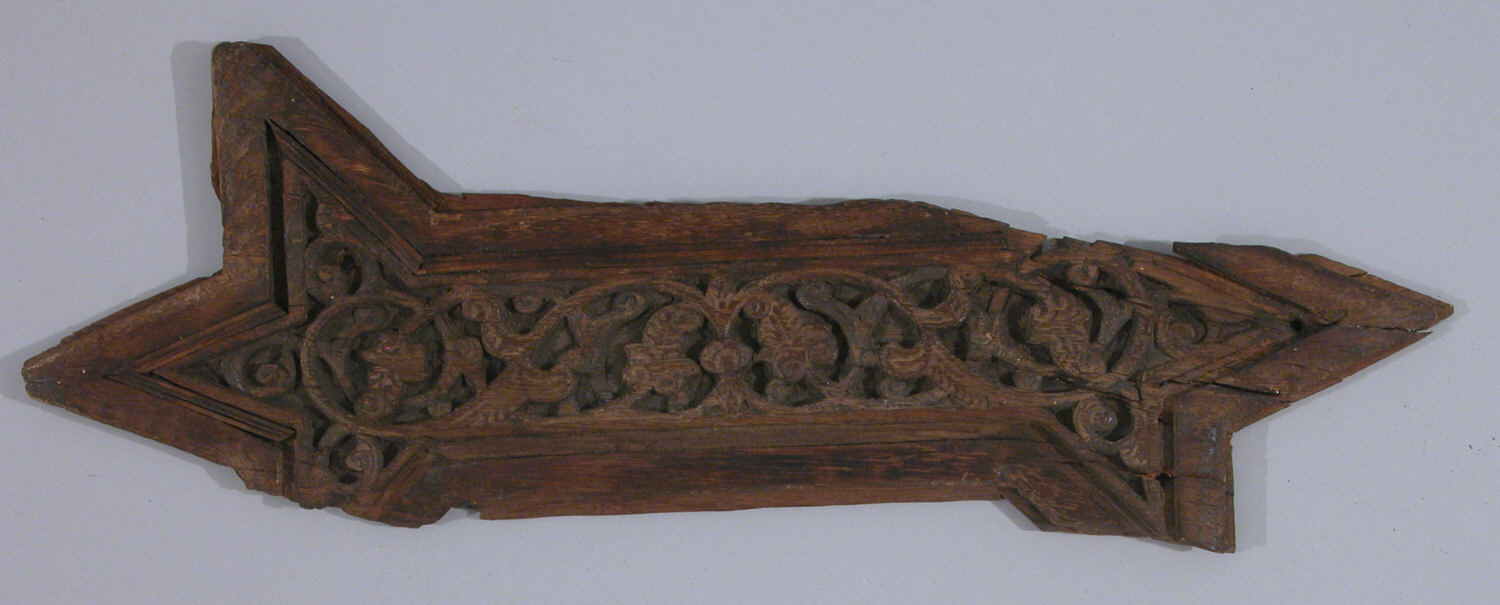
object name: panel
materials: wood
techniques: carving, inlay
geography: egypt